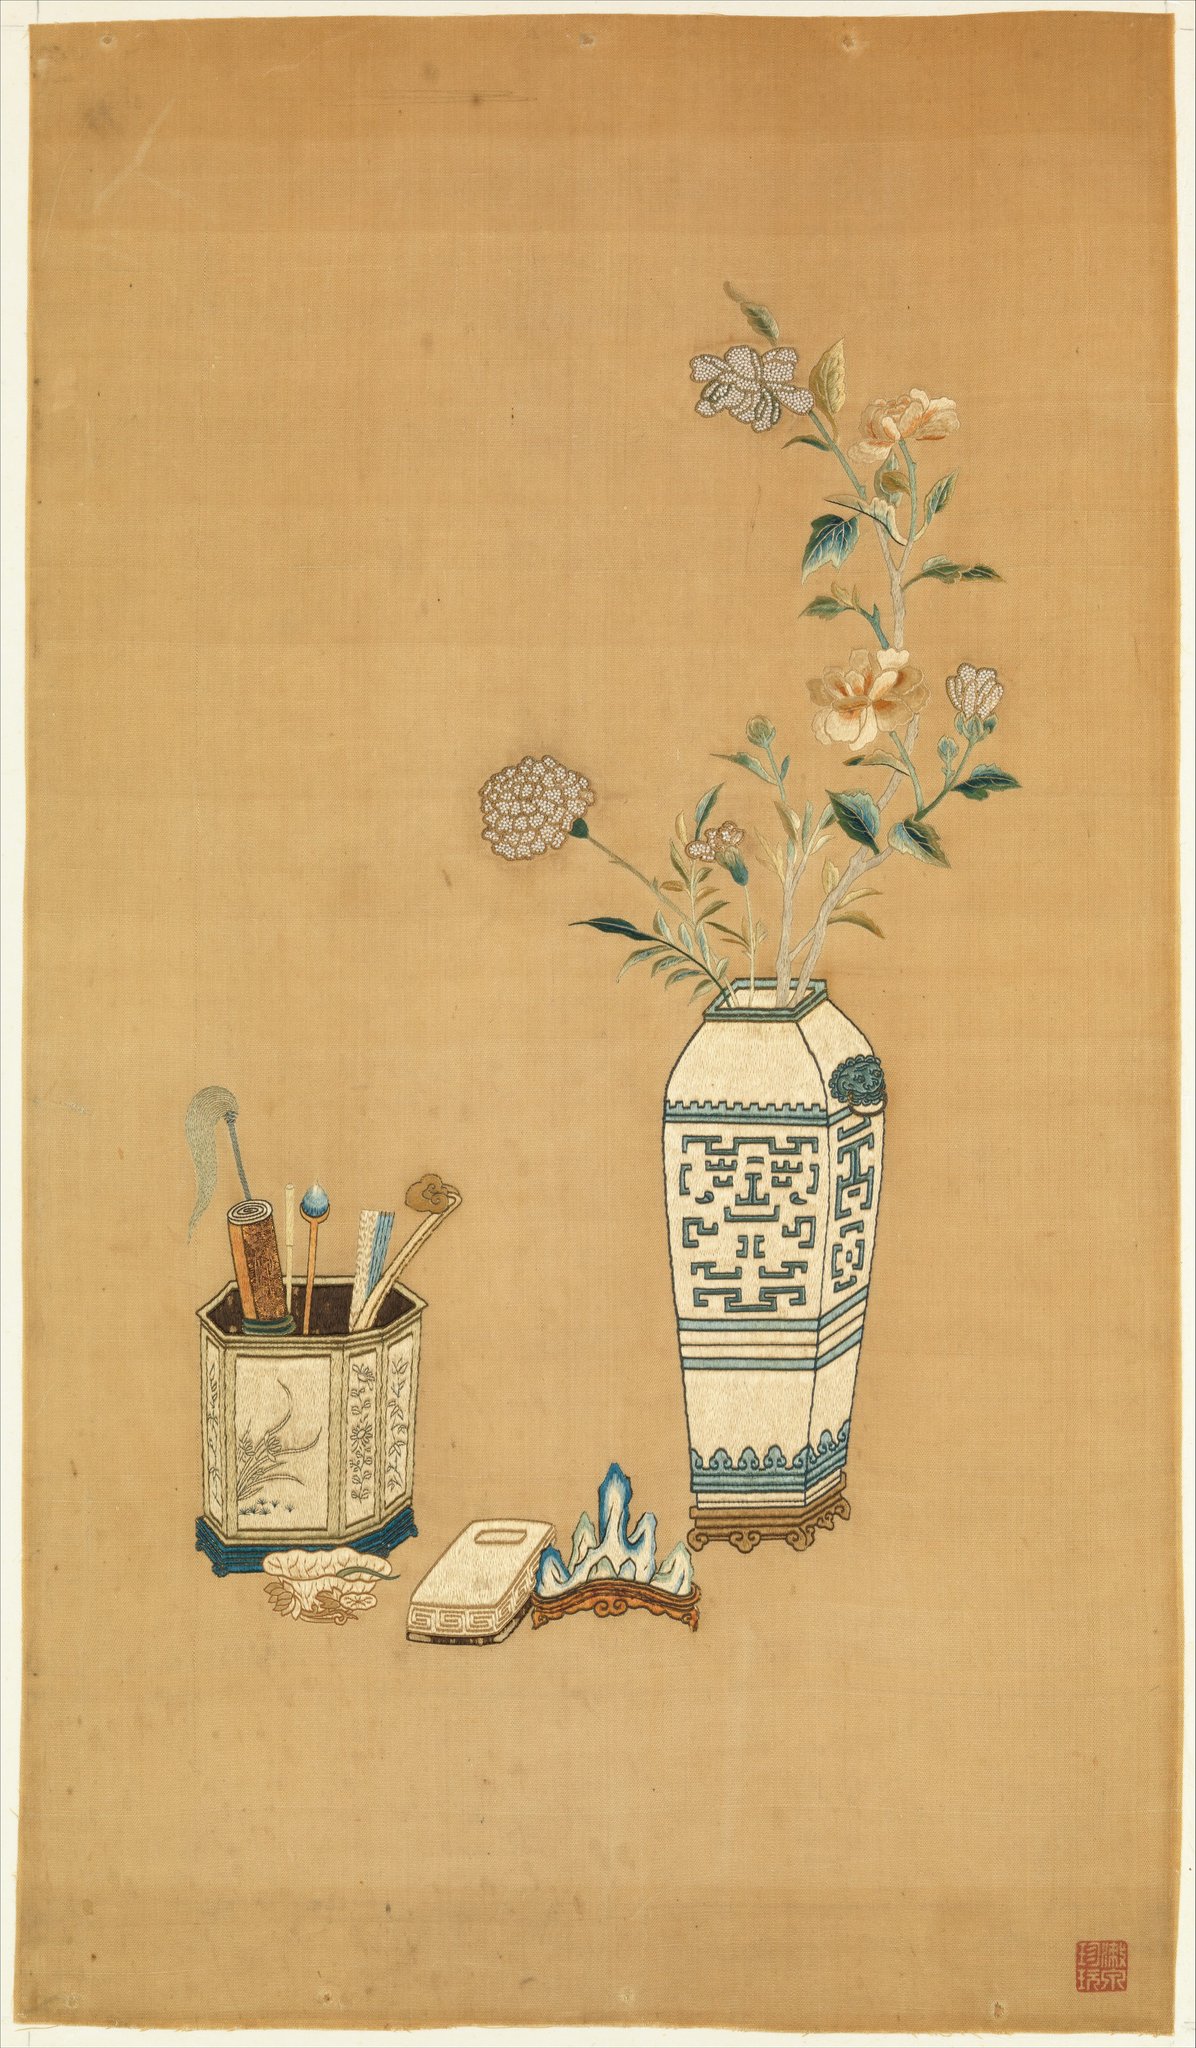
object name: textile panel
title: Panel with Flowers in Vase and Scholar's Objects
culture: chinese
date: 1701-1800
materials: metal thread, pearl, silk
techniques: embroidery, weave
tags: flowers,brushes